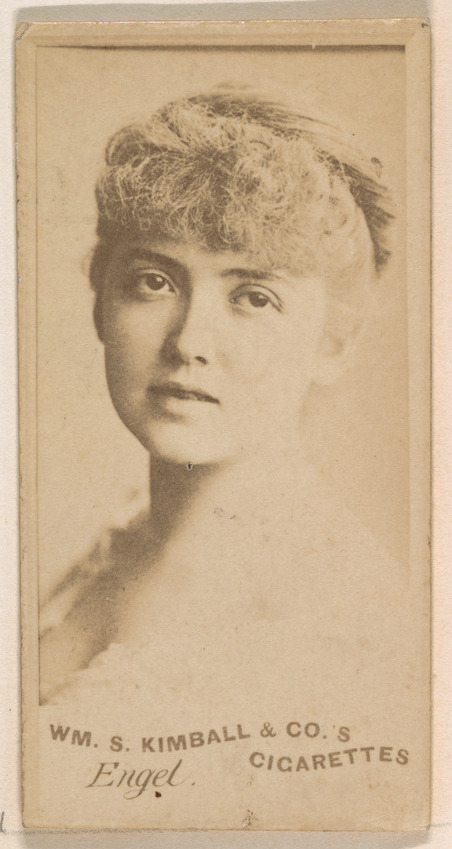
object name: photograph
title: Miss Engel, from the Actresses series (N203) issued by Wm. S. Kimball & Co.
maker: william s. kimball & company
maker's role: publisher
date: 1889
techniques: color lithograph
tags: portraits,women,actresses